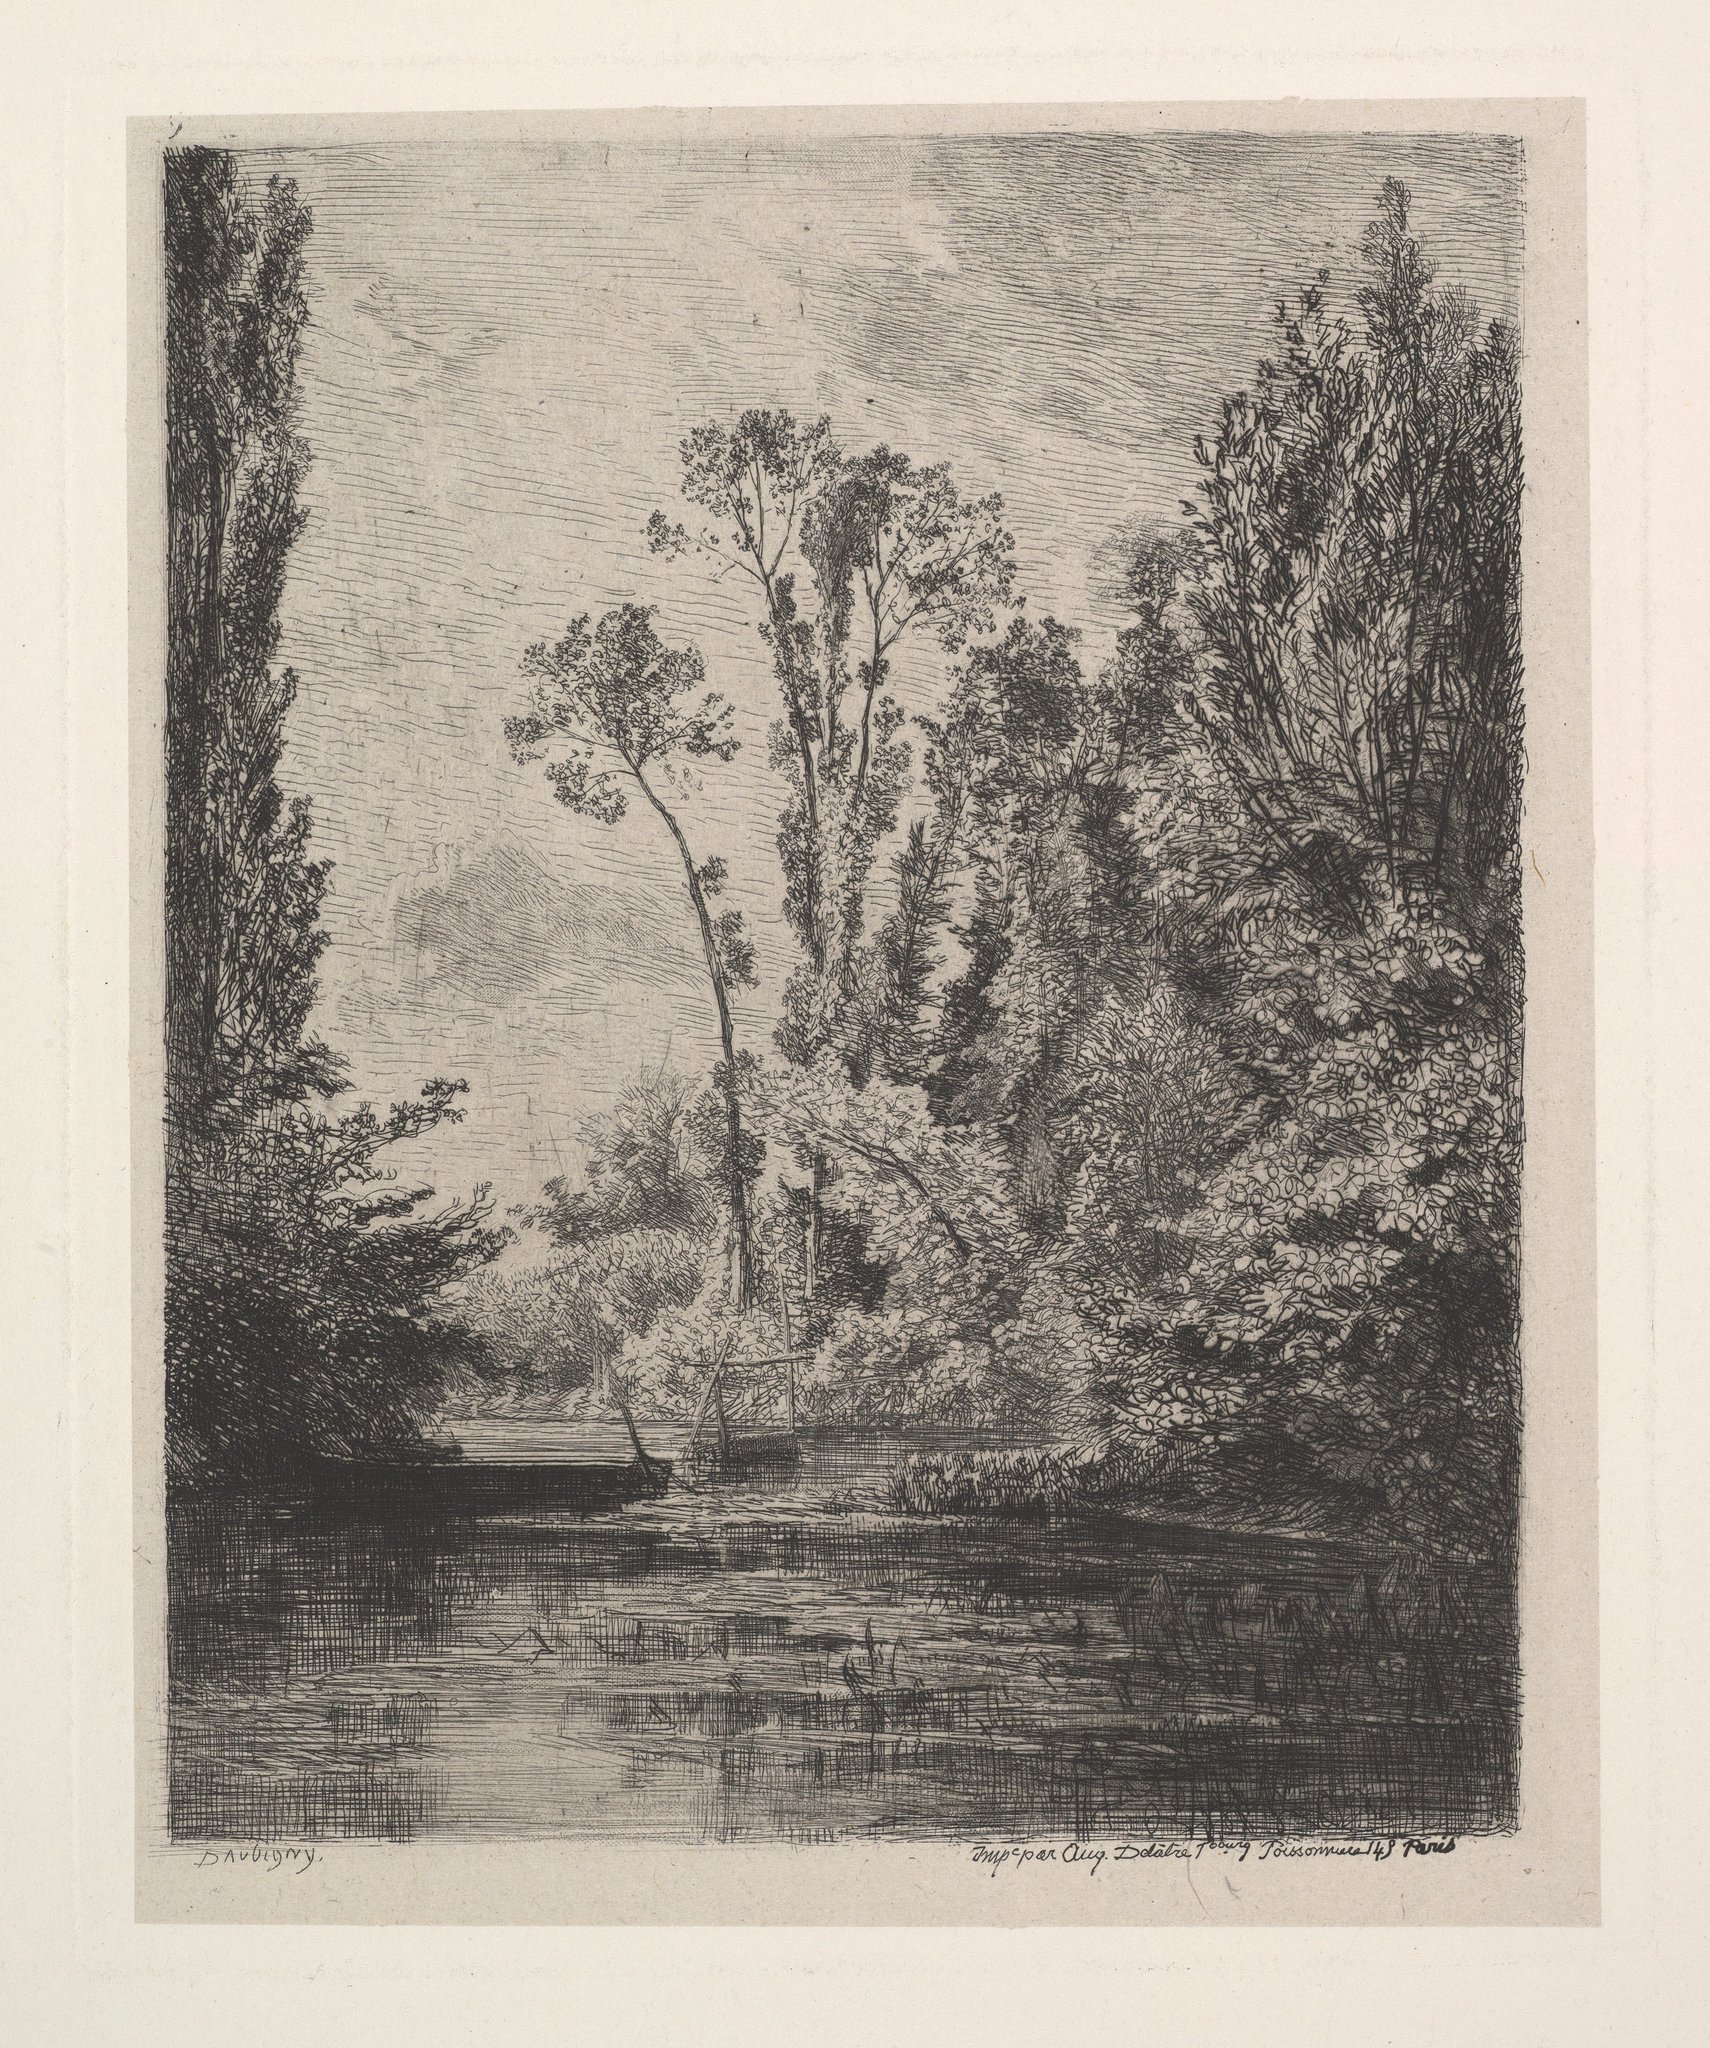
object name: print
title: The Virgin Islands at Bezon (The Fish Pond)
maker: charles-françois daubigny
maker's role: artist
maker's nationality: french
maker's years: 1817-1878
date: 1850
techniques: etching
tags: landscapes